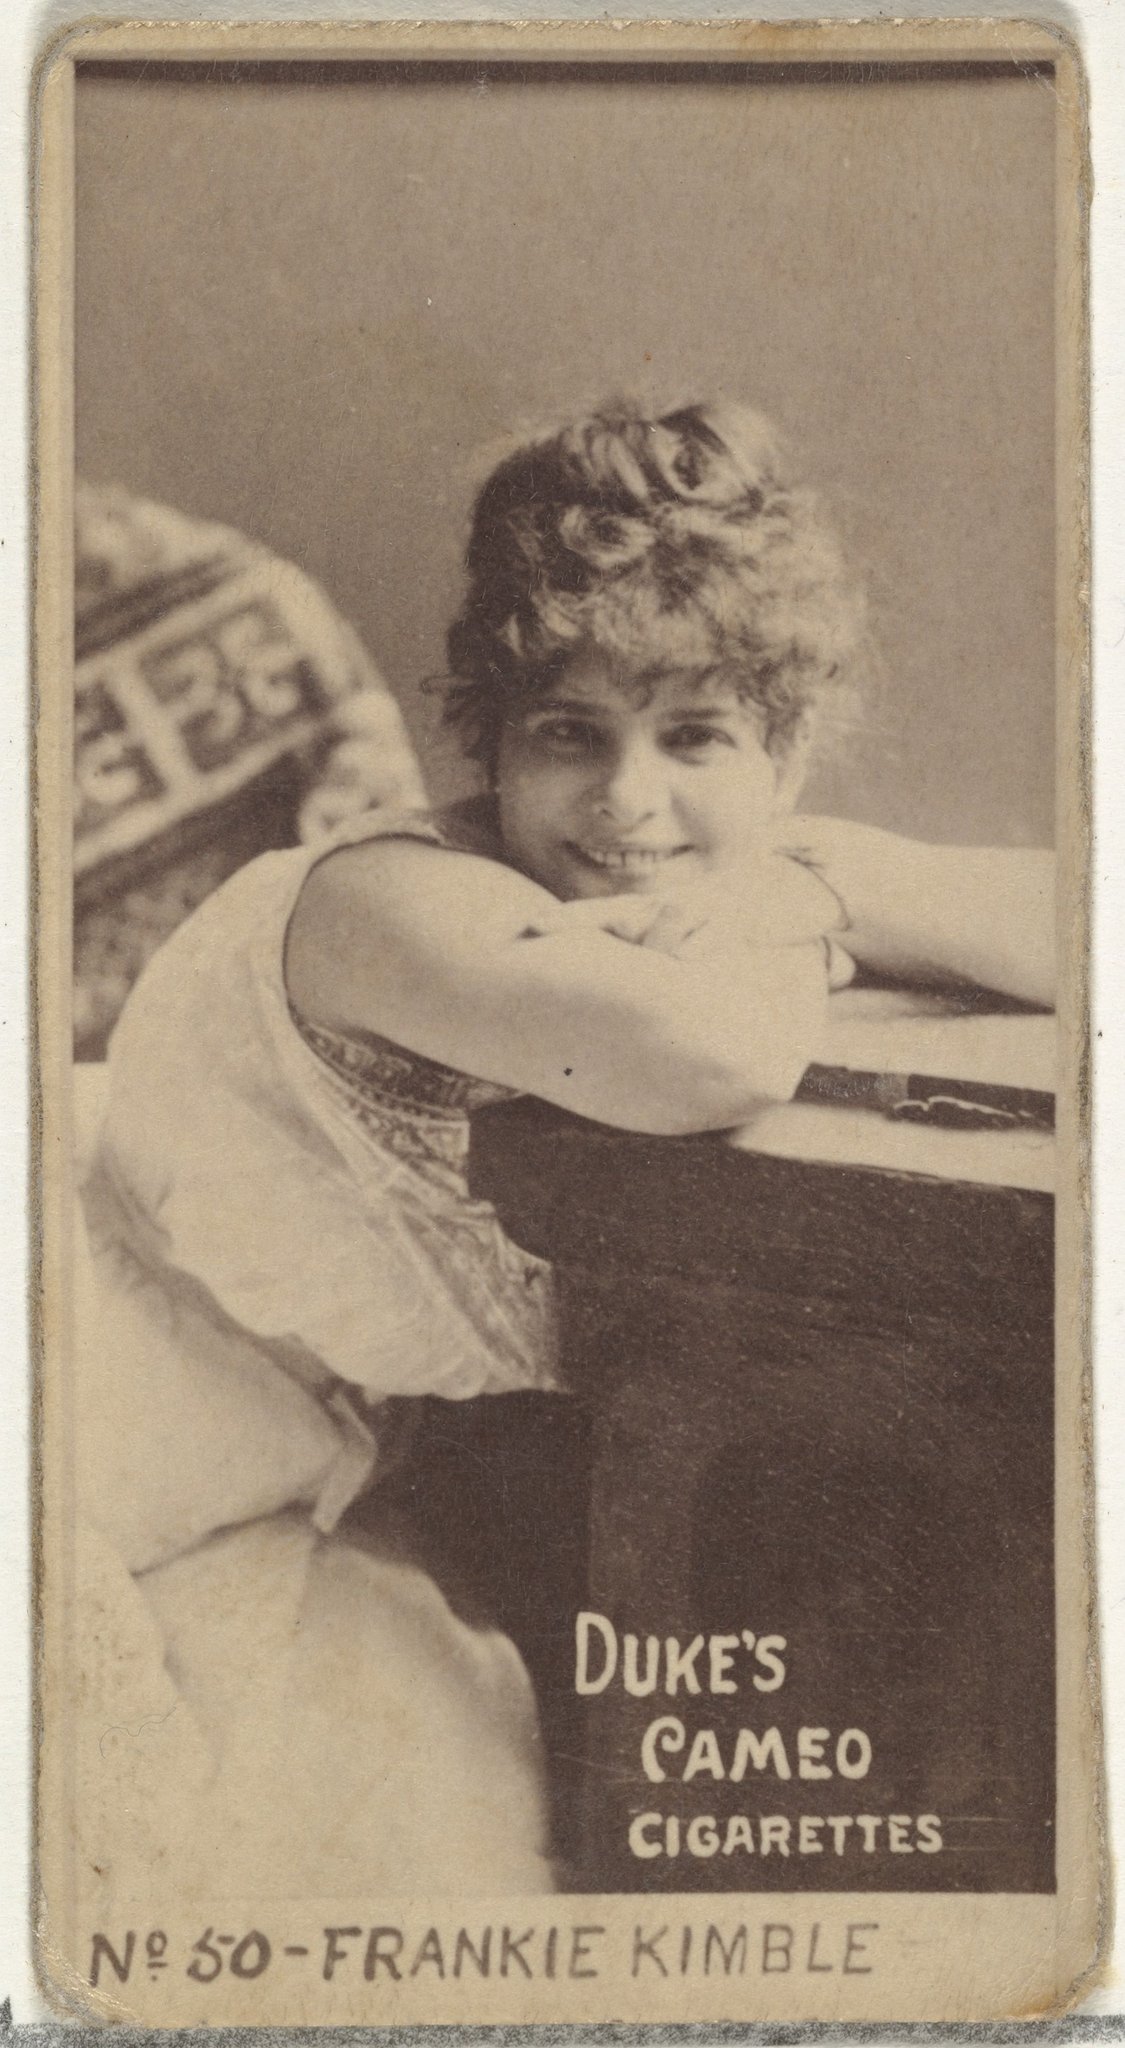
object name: photograph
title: Card Number 50, Frankie Kimble, from the Actors and Actresses series (N145-4) issued by Duke Sons & Co. to promote Cameo Cigarettes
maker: w. duke, sons & co.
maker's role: publisher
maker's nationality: american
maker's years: 1870-1920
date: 1880-1889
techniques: albumen silver print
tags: portraits,women,actresses